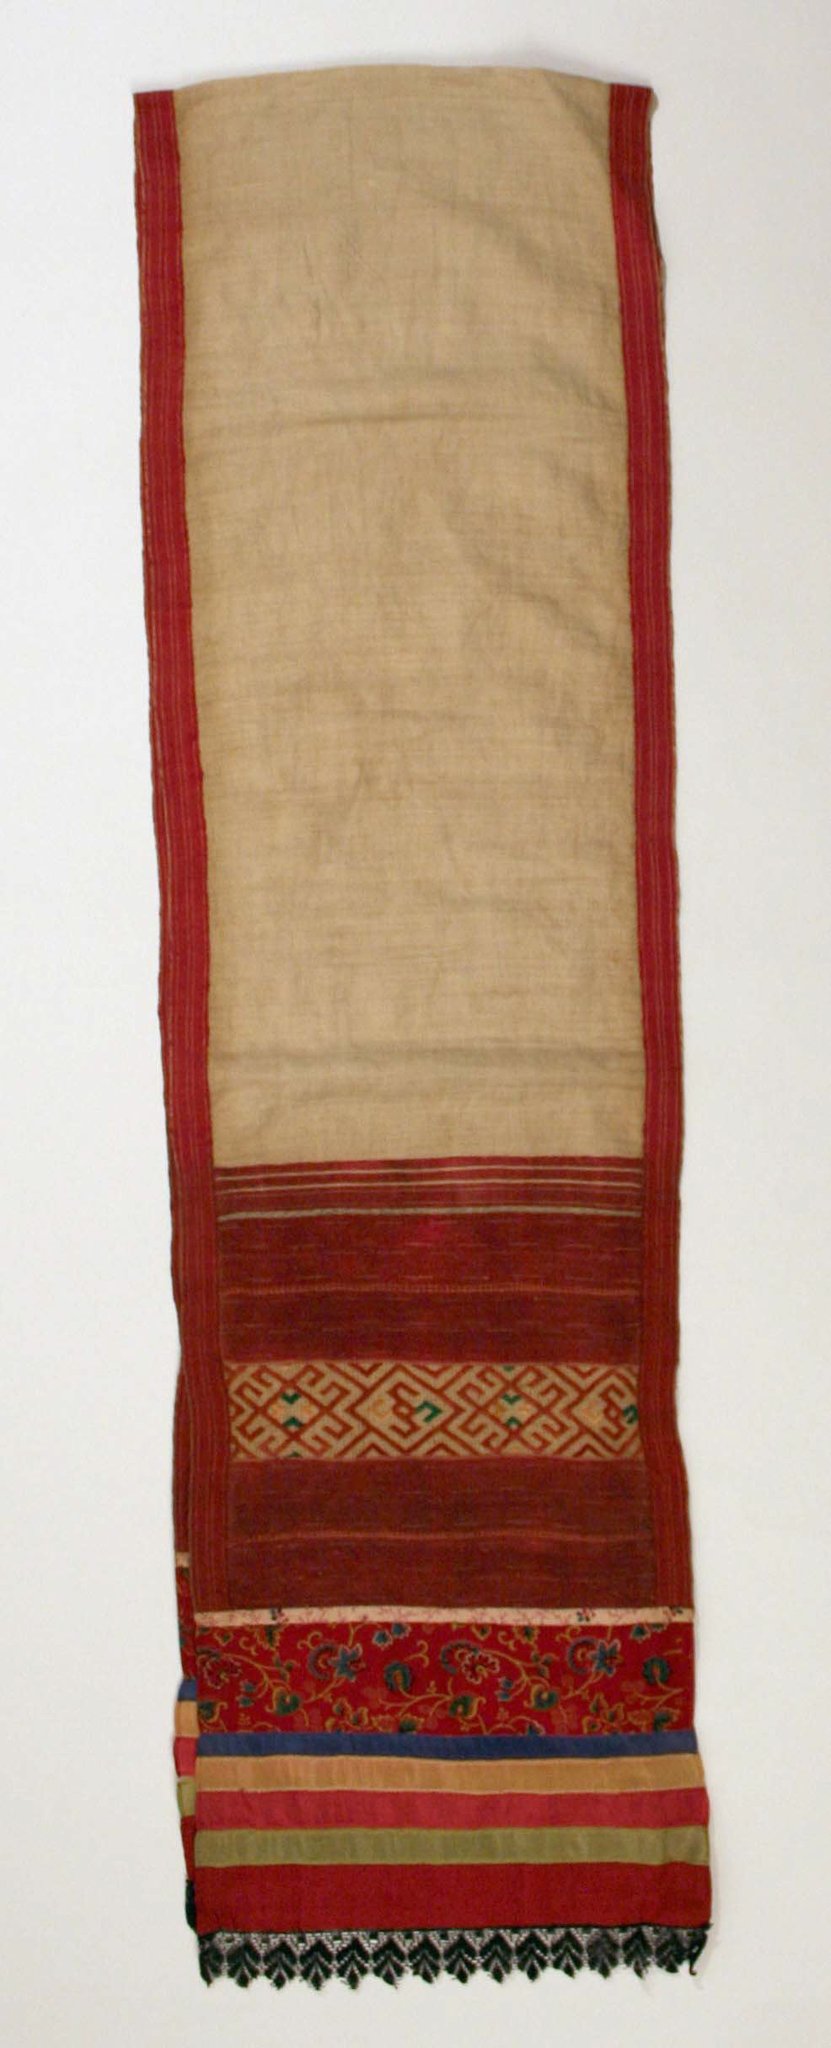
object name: headscarf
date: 1801-1900